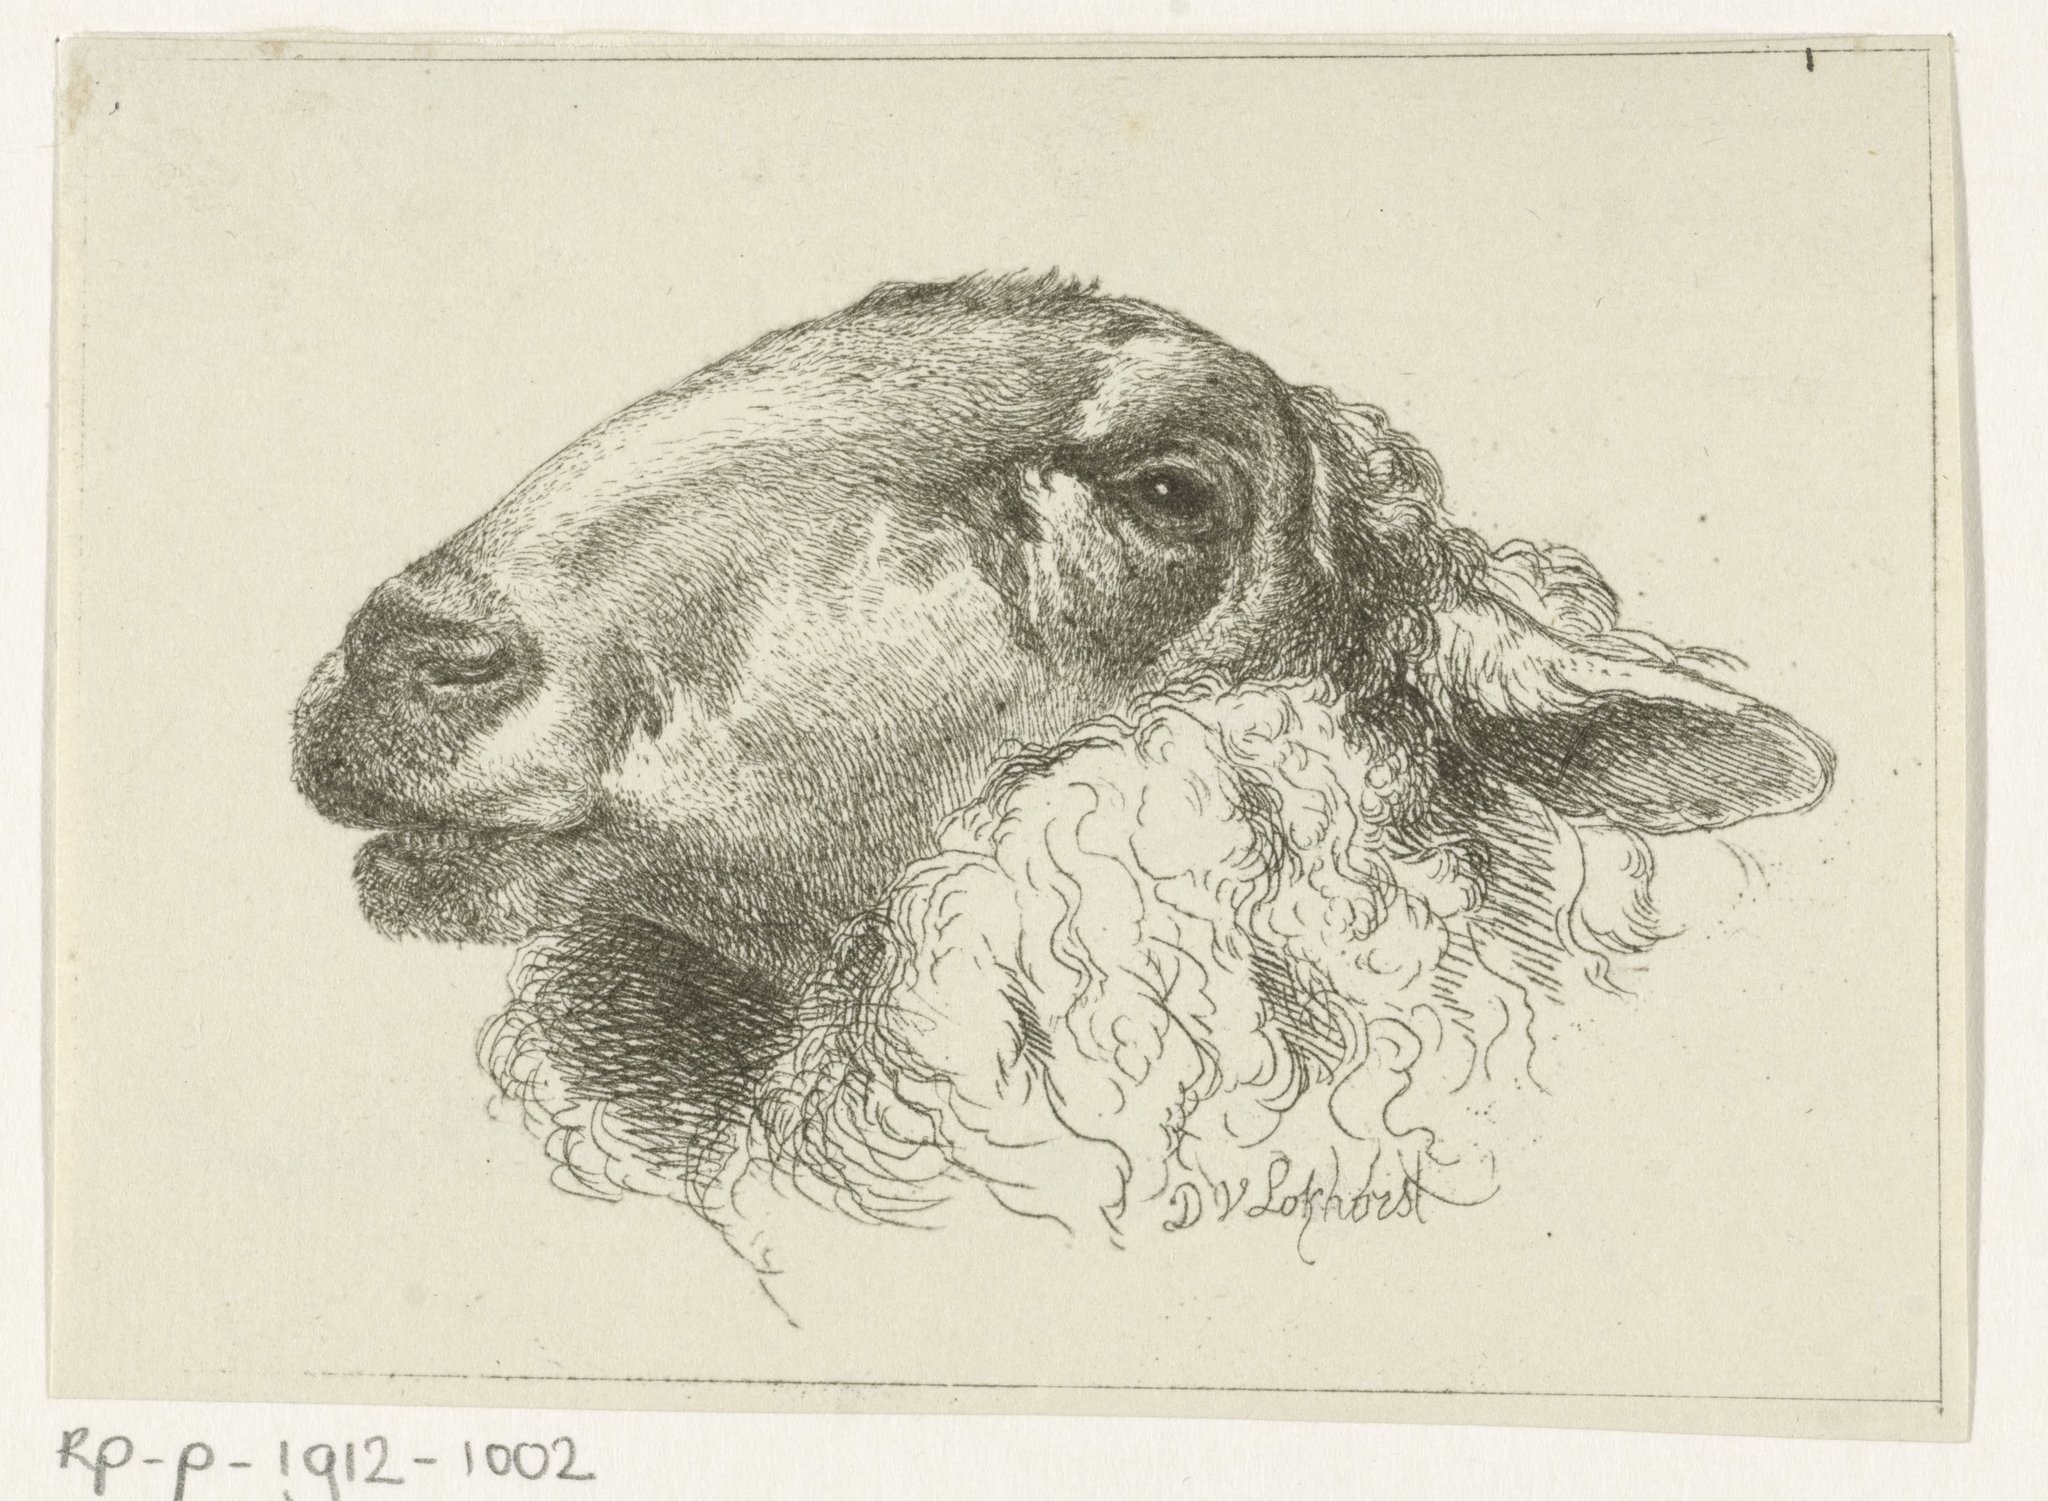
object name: print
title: Kop van een schaap, naar links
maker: dirk van lokhorst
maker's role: draughtsman, painter, print maker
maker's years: 1818-1893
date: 1828-1893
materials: paper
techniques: etching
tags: sheep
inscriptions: collector's mark: Lugt 2228